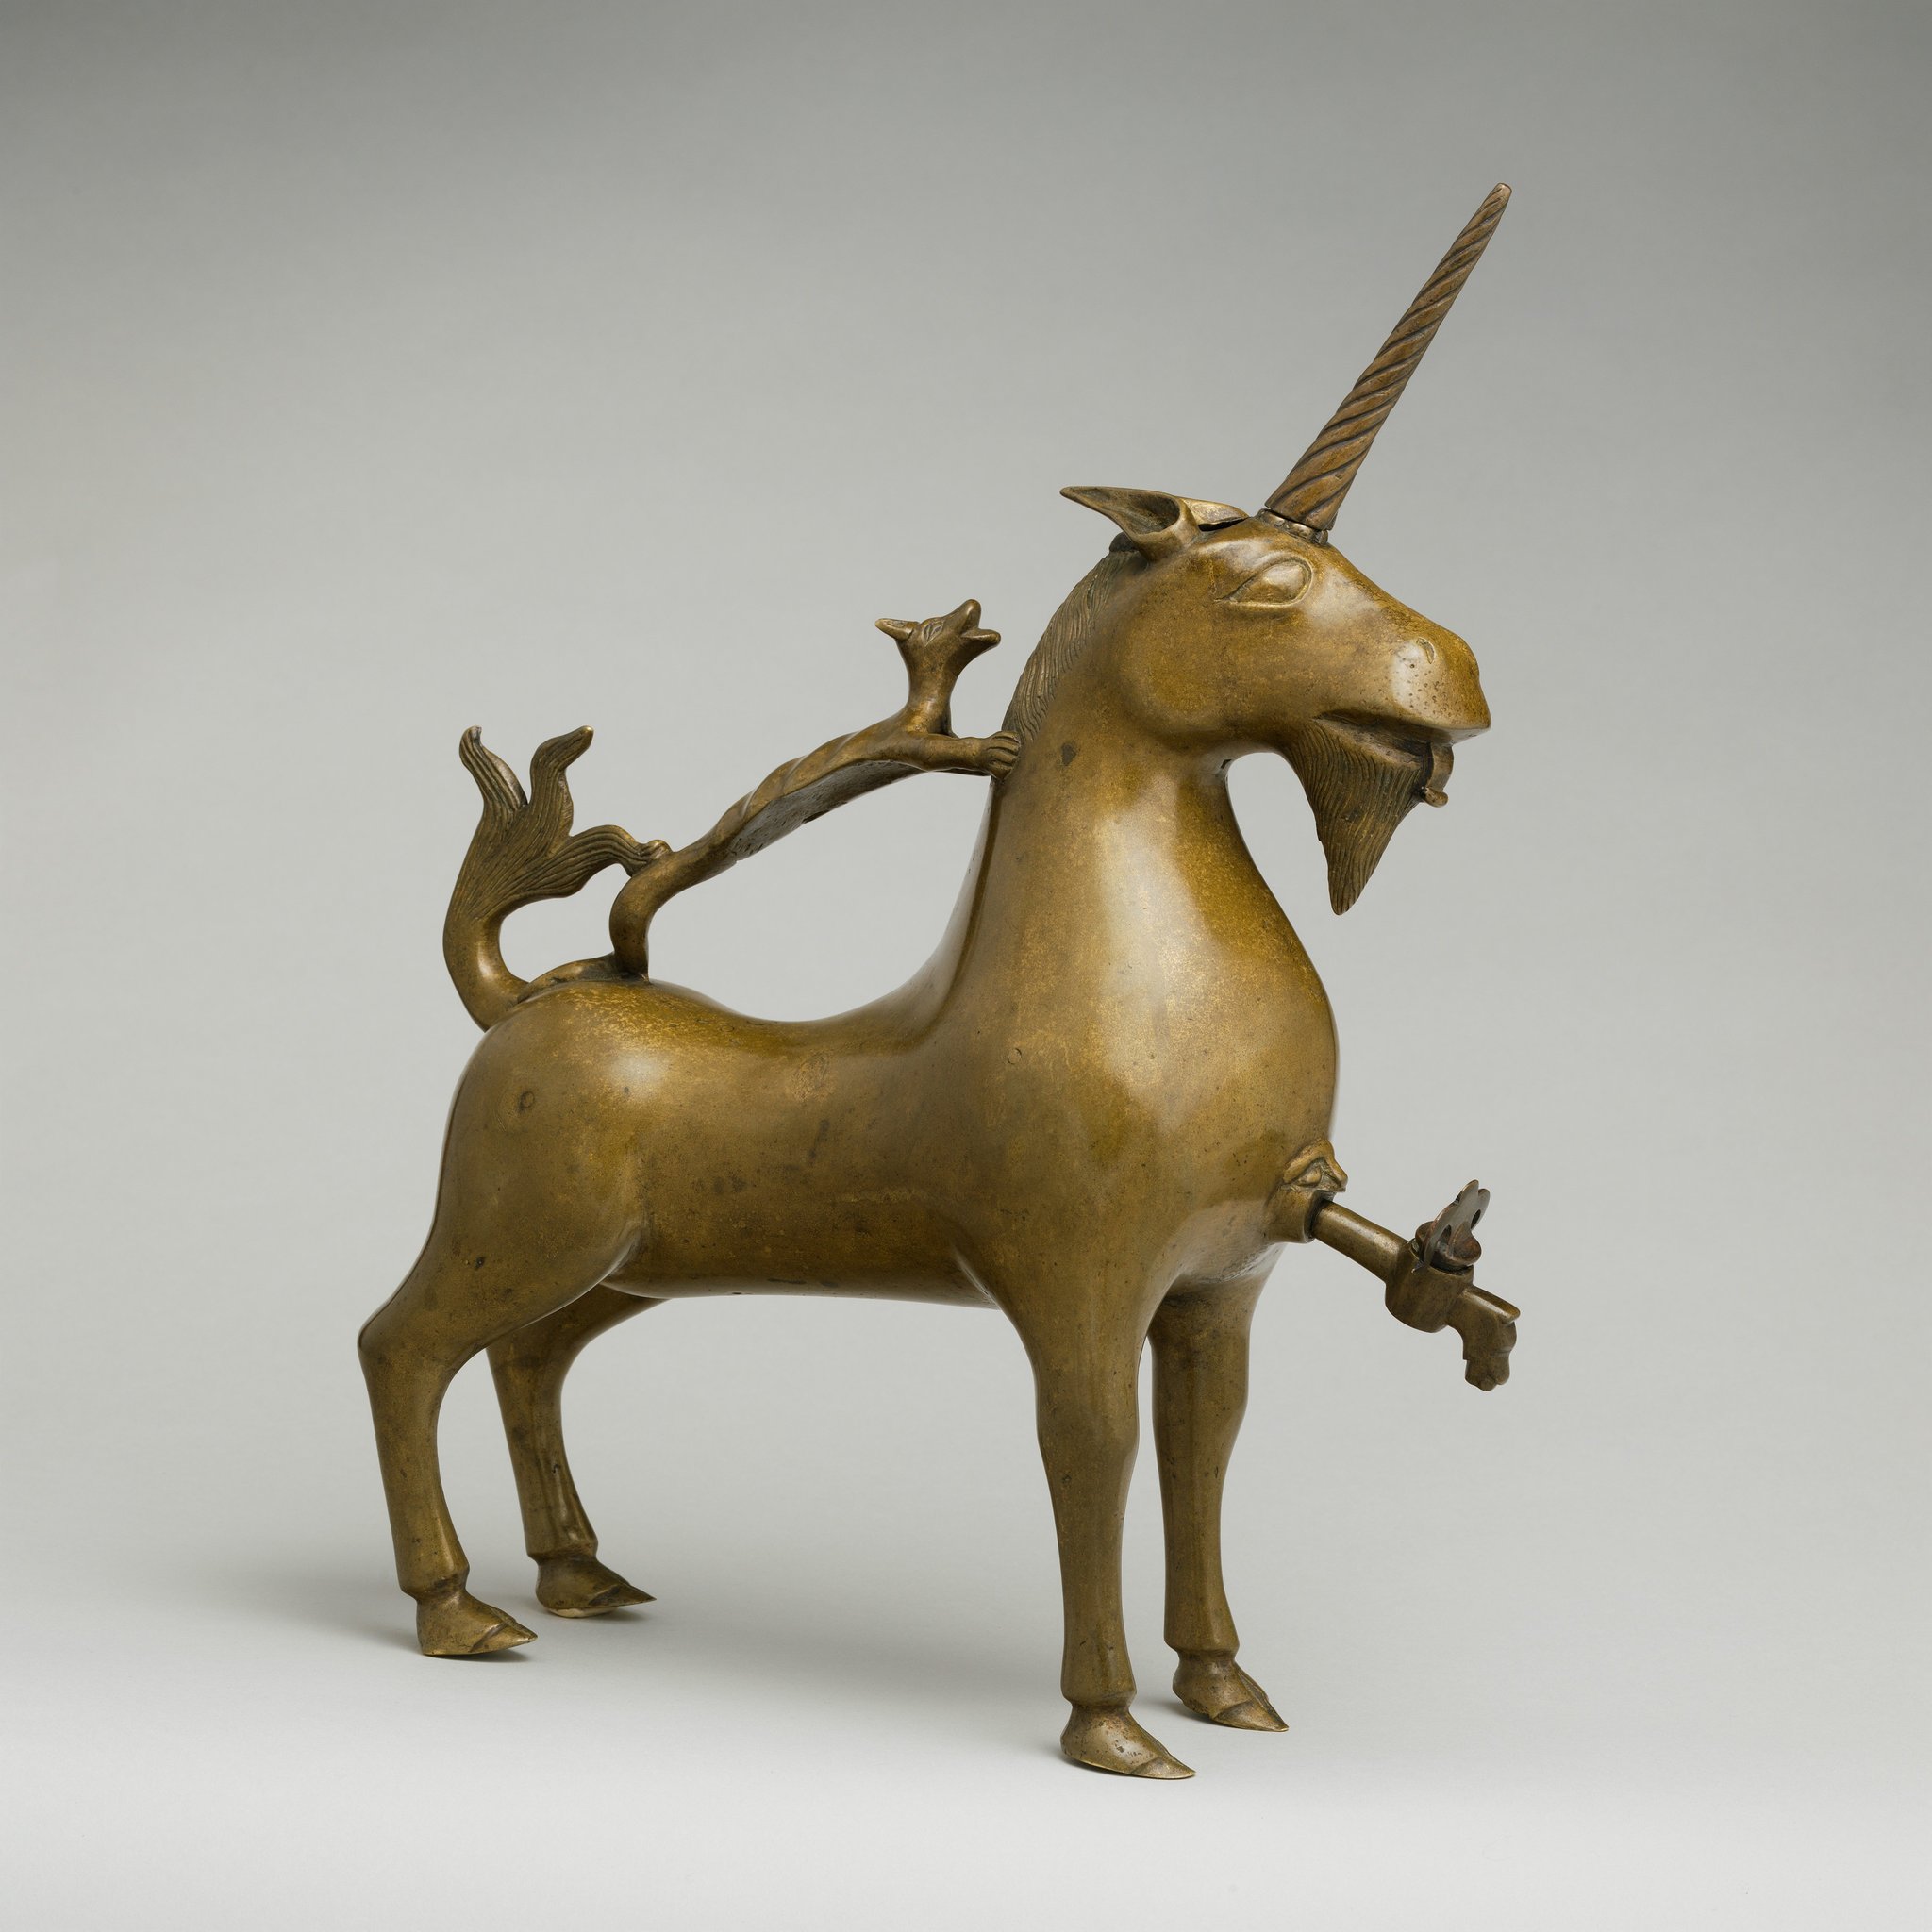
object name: aquamanile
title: Aquamanile in the Form of a Unicorn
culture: german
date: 1425-1450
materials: copper alloy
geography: germany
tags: unicorns